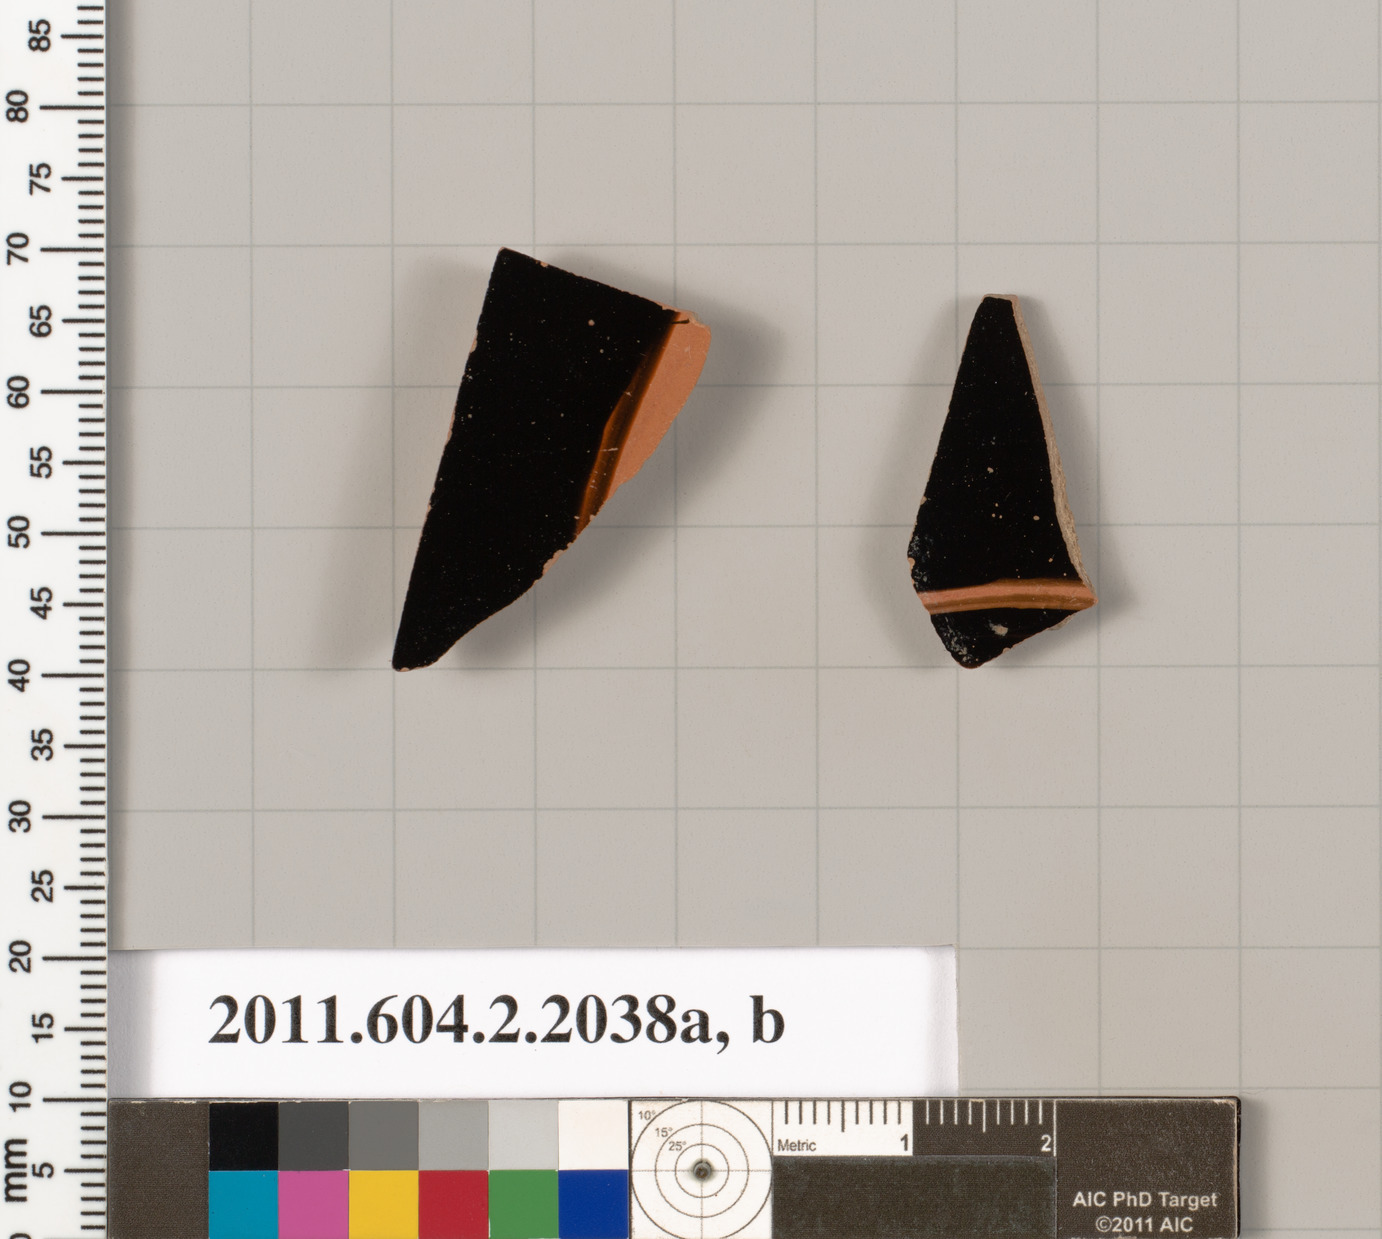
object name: pot fragment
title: Terracotta fragments of pots; glazed on the inside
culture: greek, attic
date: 600-401 BCE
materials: terracotta